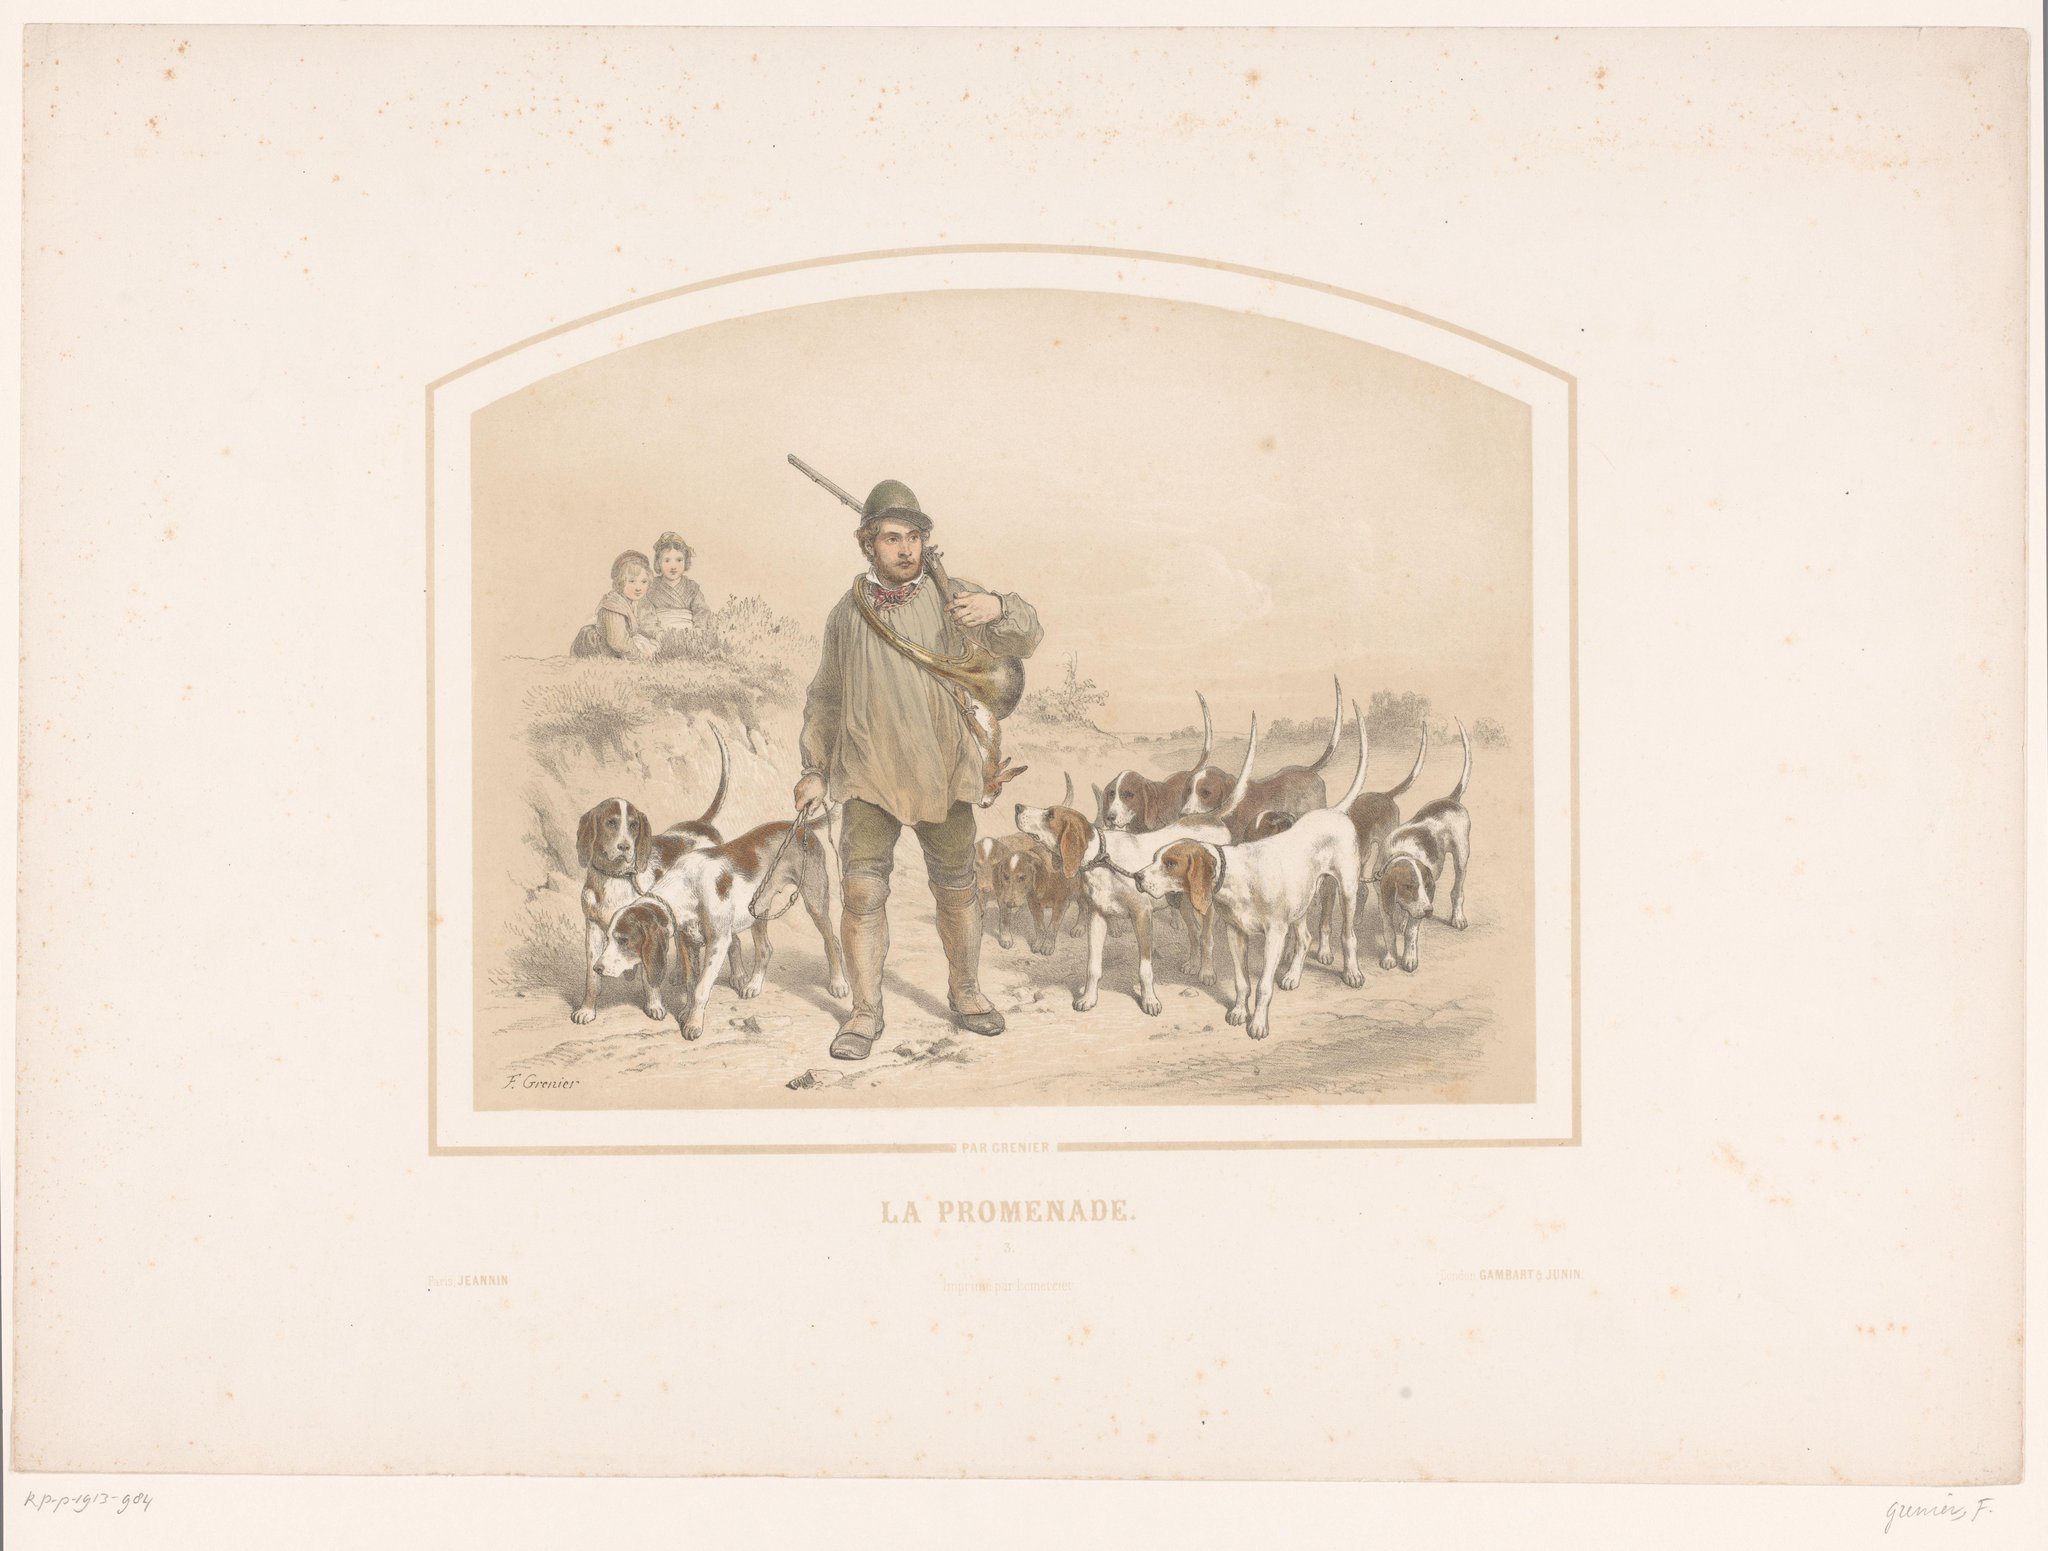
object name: print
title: La promenade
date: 1819-1854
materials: paper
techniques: hand coloring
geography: paris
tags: hunting dogs, hunter, hare-hunting, rabbit-hunting, walking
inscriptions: check stamp: Lugt 5002, collector's mark: Lugt 2228a